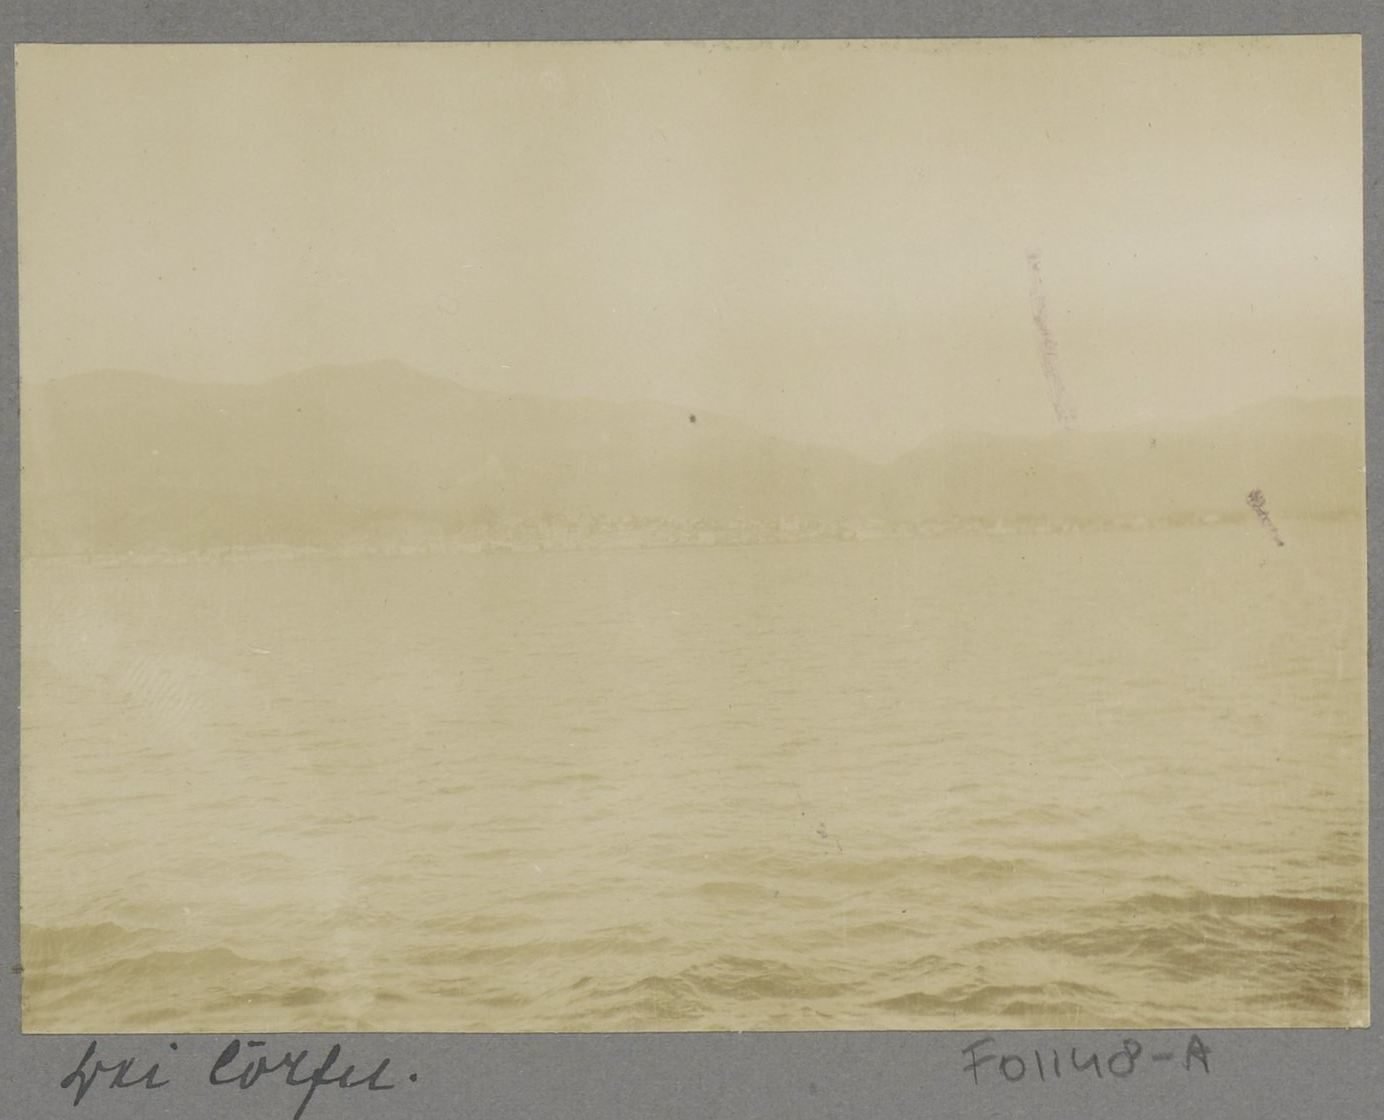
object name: album leaf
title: Gezicht op een baai bij Corfu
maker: Anonymous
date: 1905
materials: paper, photographic support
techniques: gelatin silver print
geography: corfu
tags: gulf, bay (+ landscape with figures, staffage)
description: Onderdeel van Reisalbum met foto's van bezienswaardigheden in Griekenland en Egypte.